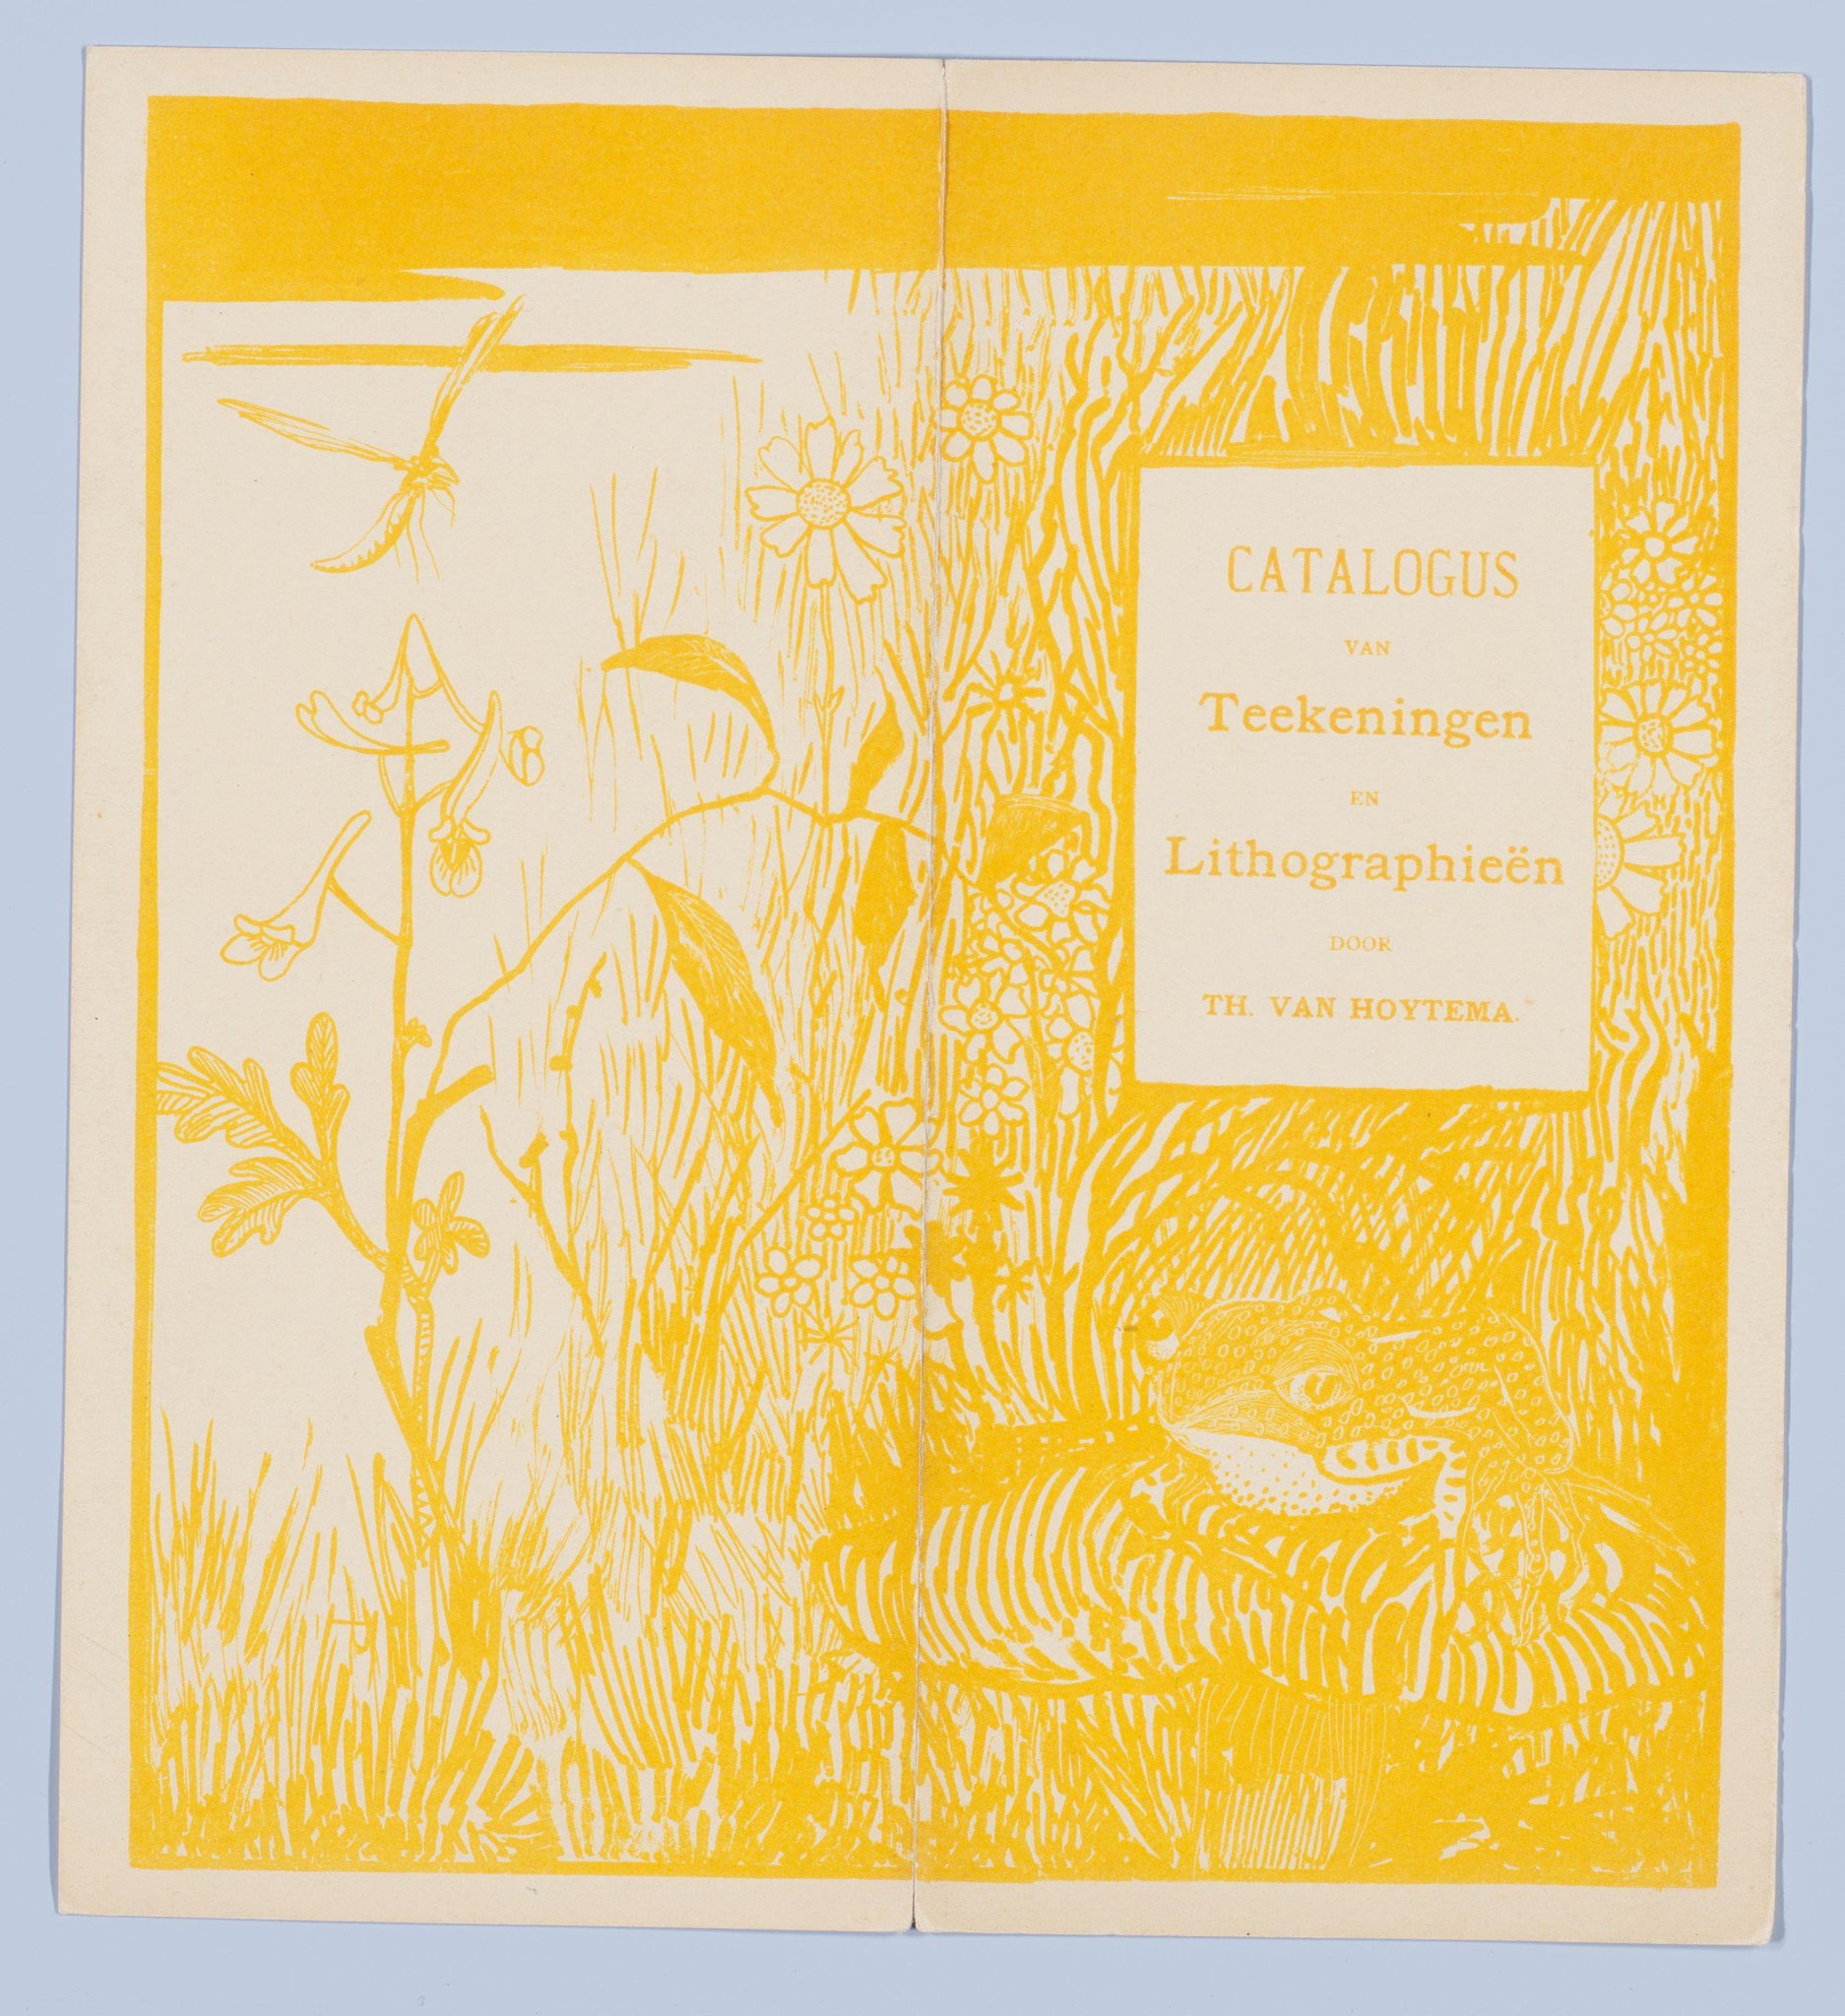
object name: catalog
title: Catalogusomslag met pad en libelle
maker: theo van hoytema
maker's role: draughtsman, painter, print maker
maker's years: 1863-1917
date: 1878-1917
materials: paper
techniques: lithograph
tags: insects: dragon-fly, tailless amphibians: toad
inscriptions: collector's mark: Lugt 2228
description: Catalogusomslag voor een tentoonstelling van Theo van Hoytema. Links een libelle; rechts een pad tussen planten. In het omslag een vel met een lijst van tentoongestelde werken.